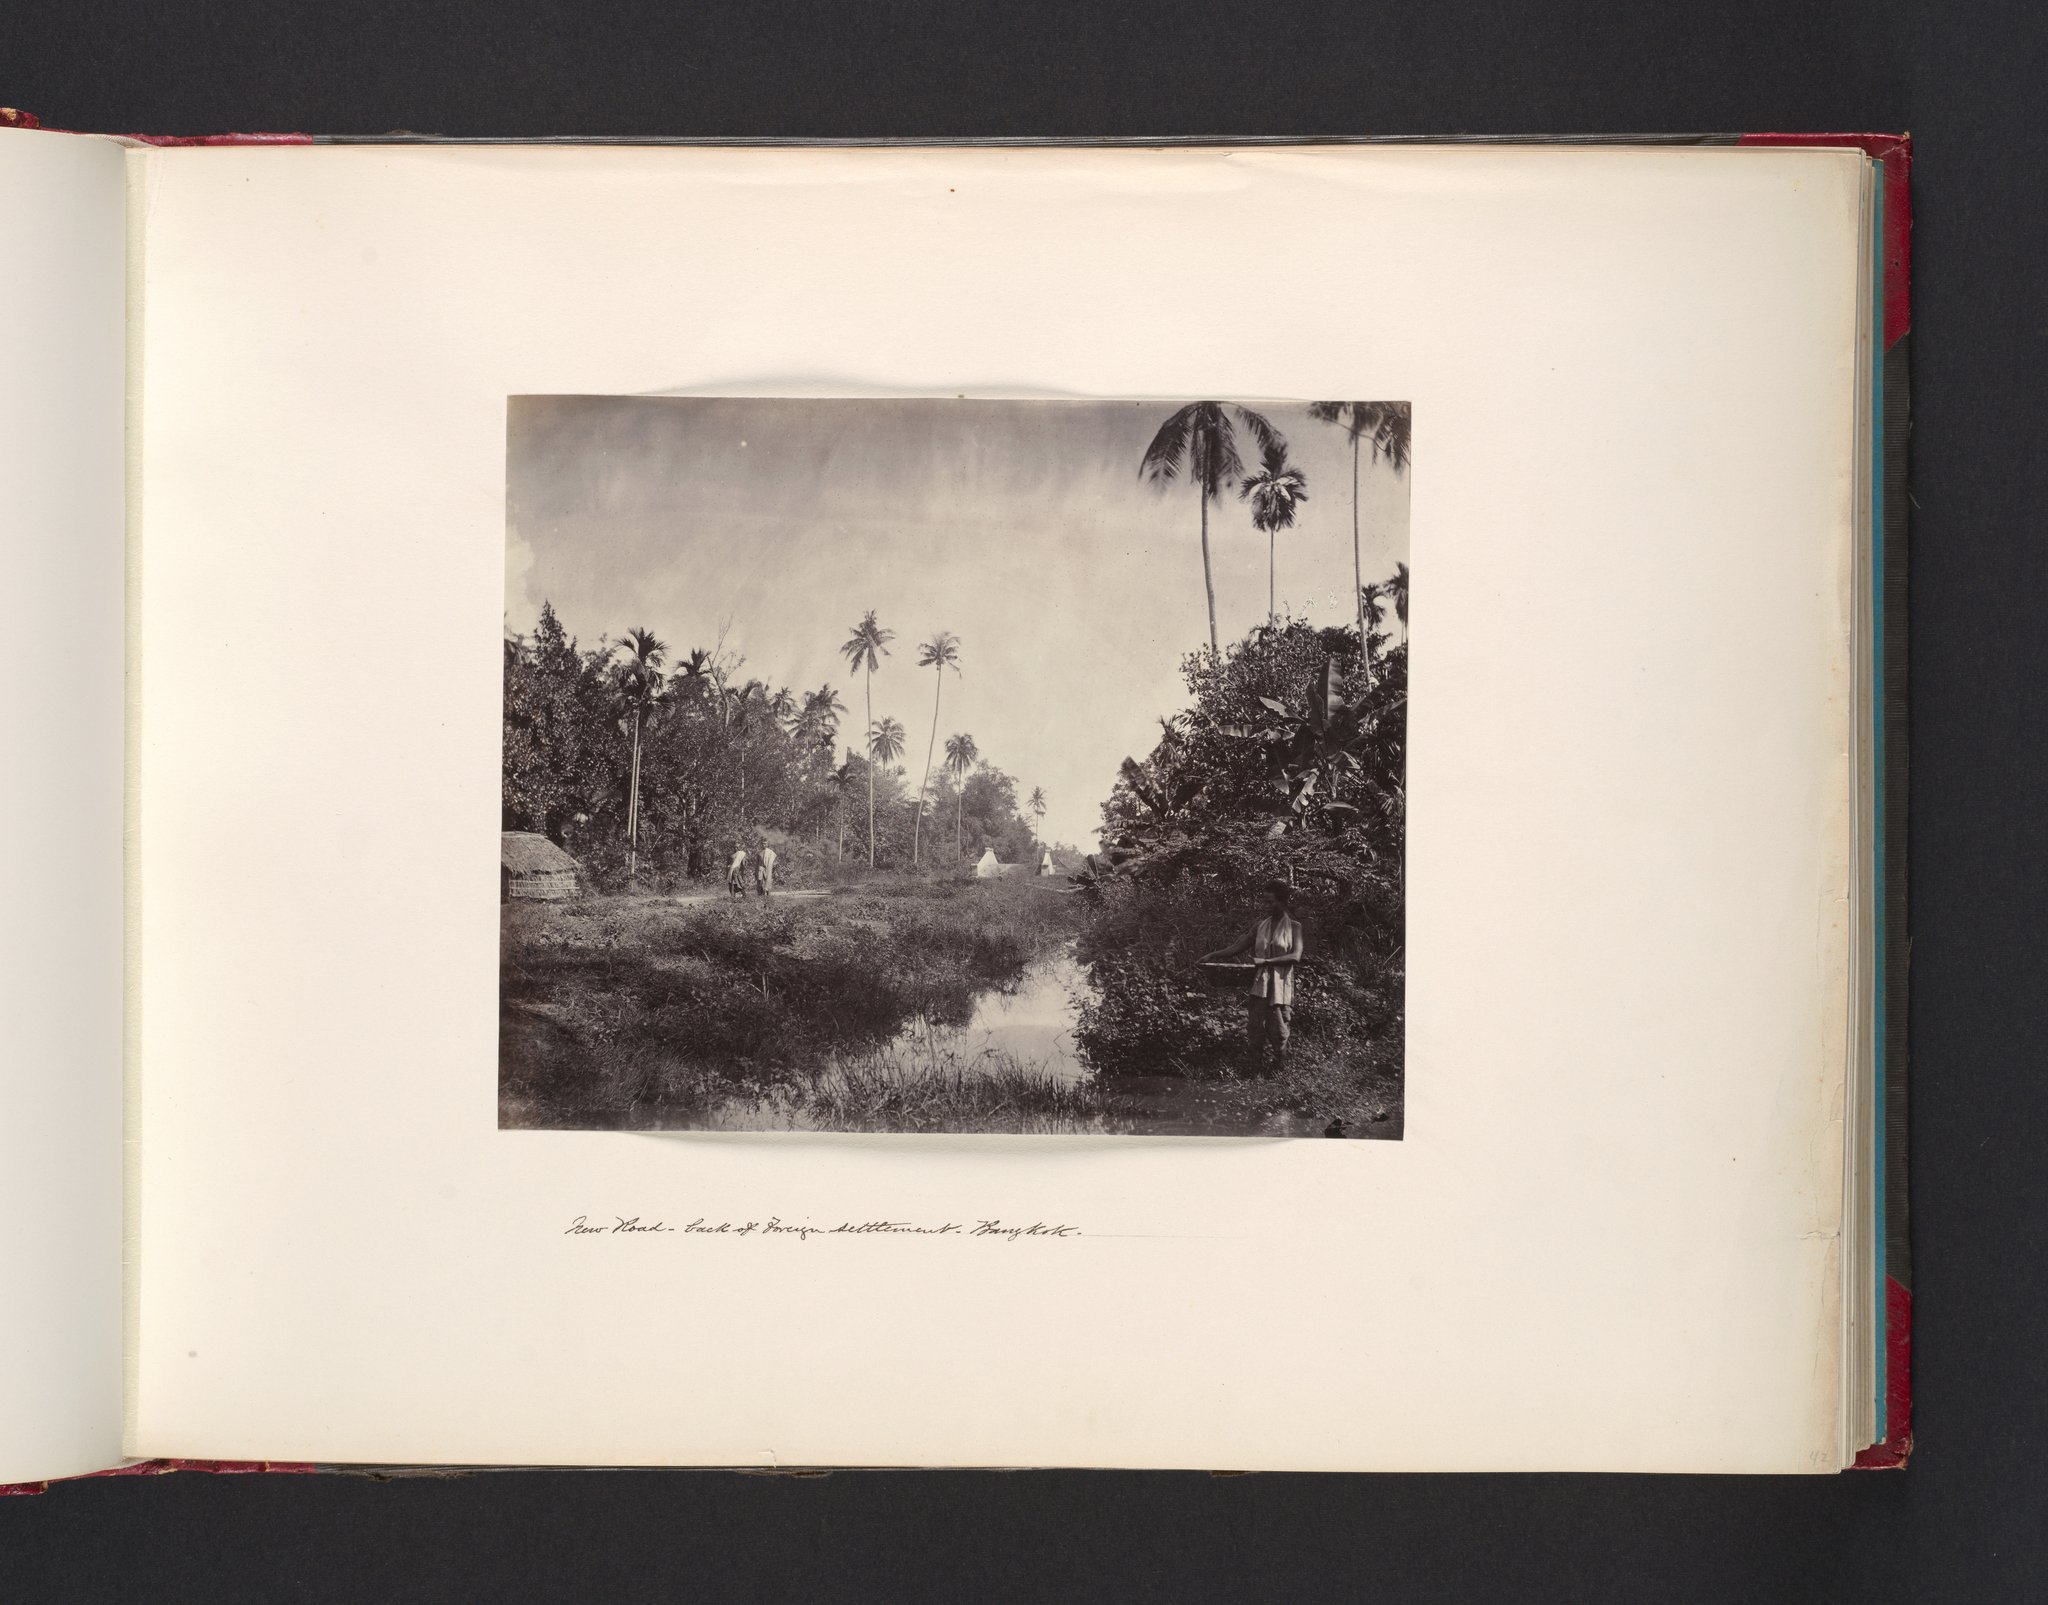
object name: photograph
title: New Home, Back of Foreign Settlement, Bangkok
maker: john thomson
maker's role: artist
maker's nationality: british, scottish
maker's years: 1837-1921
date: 1865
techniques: albumen silver print, glass negative